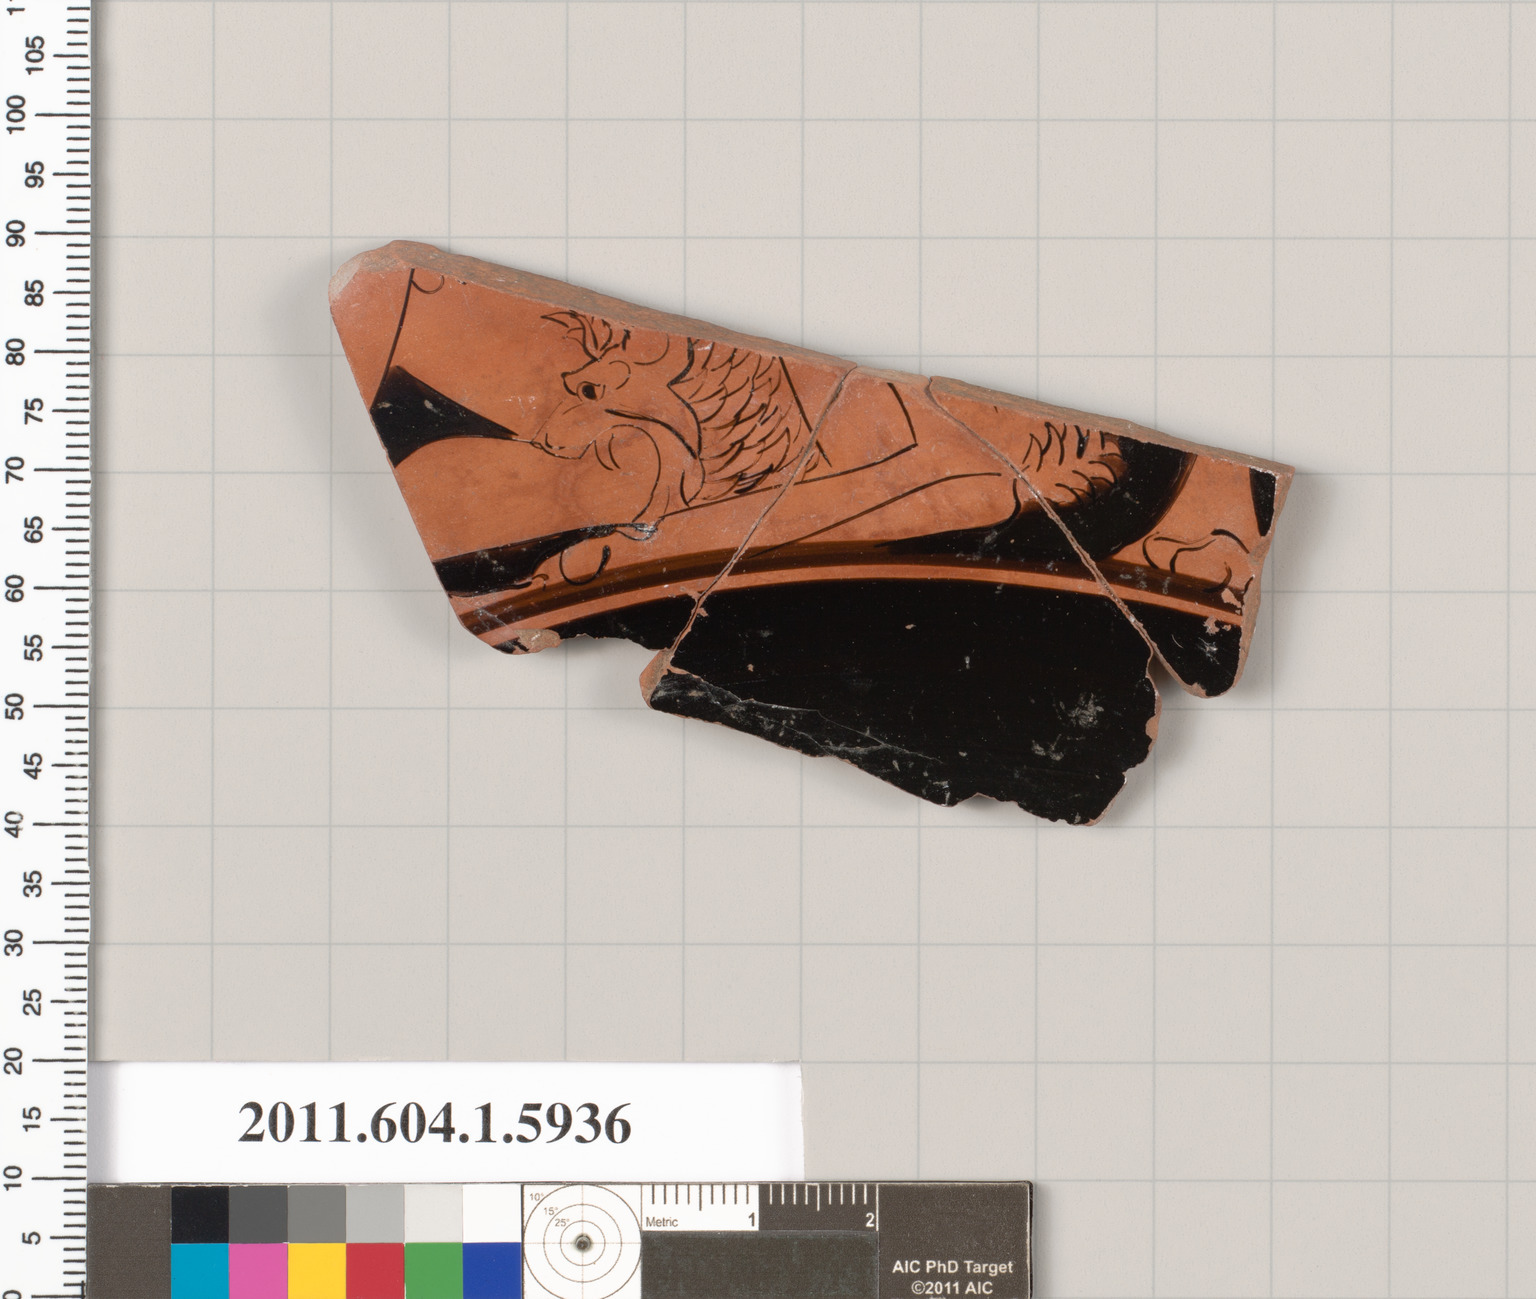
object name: kylix fragment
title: Terracotta fragment of a kylix (drinking cup)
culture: greek, attic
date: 520-510 BCE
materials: terracotta